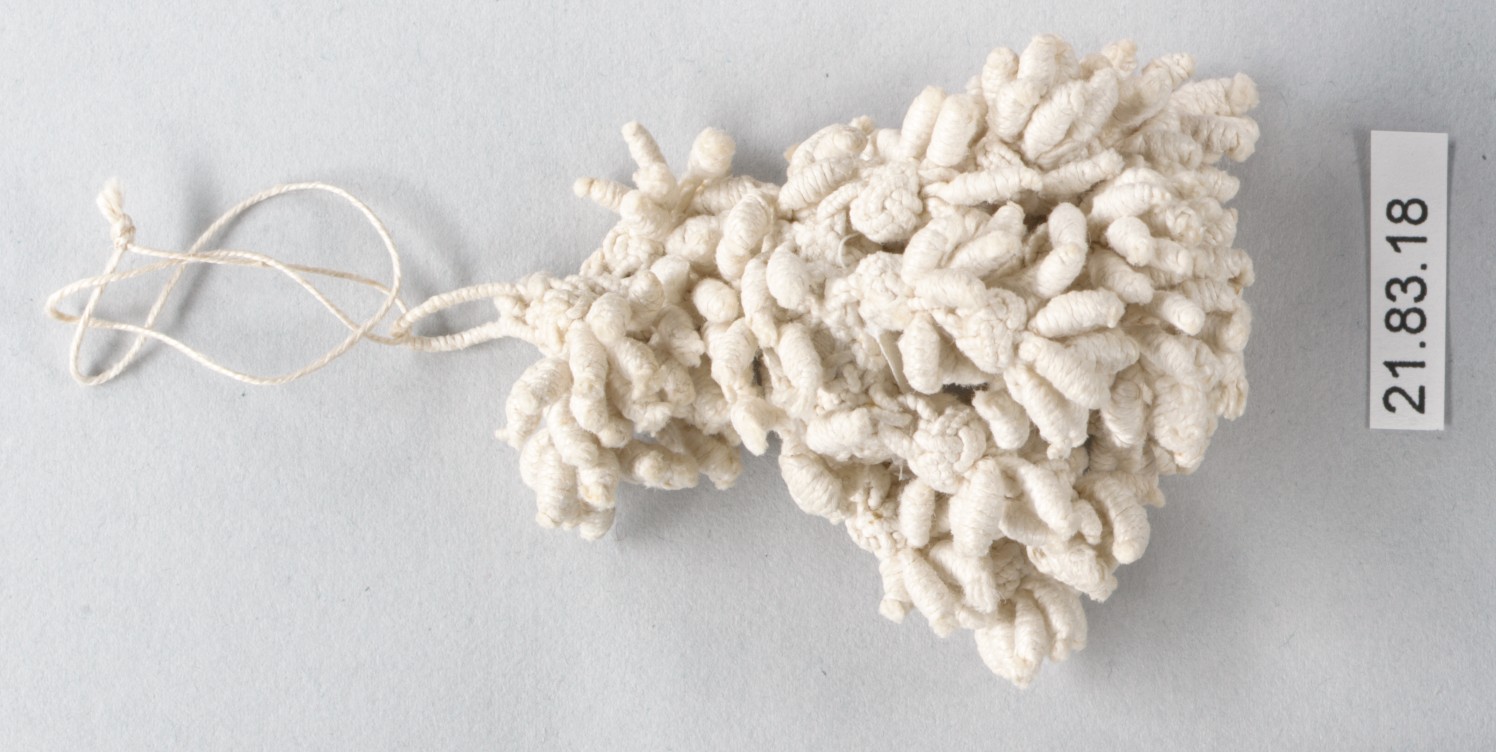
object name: tassel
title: Pair of tassels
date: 1601-1700